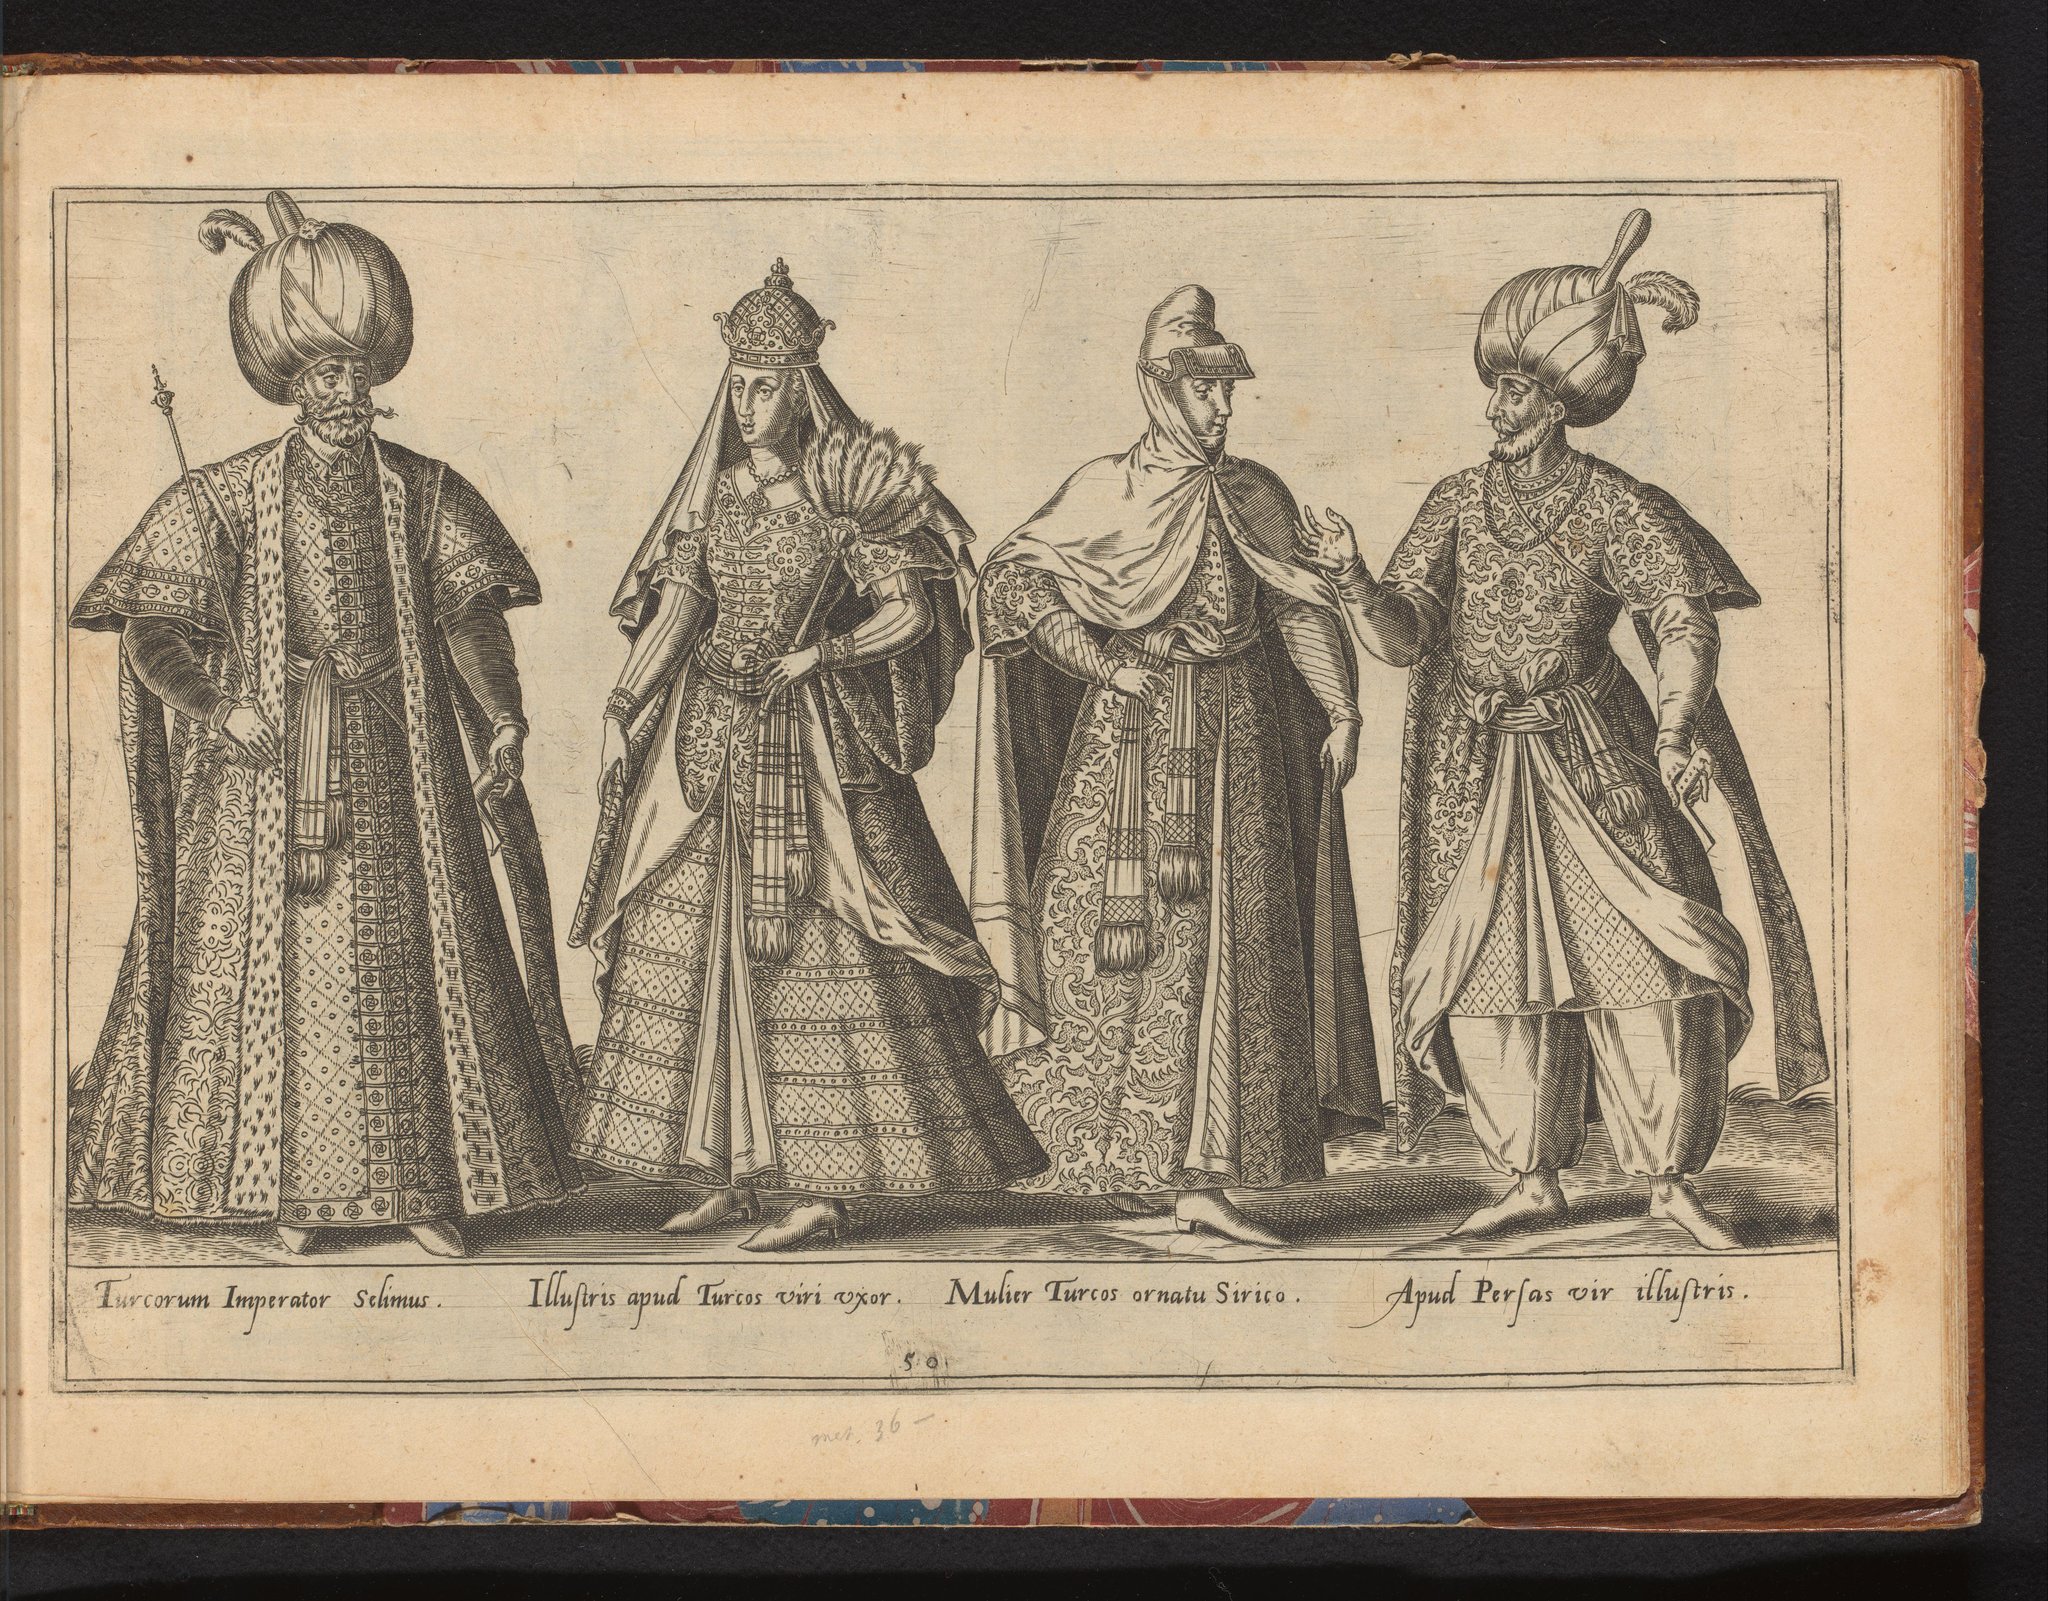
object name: costume print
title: Twee Turkse mannen en twee vrouwen, gekleed volgens de mode van ca. 1580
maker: abraham de bruyn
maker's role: print maker, publisher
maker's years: 1540-1587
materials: paper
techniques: engraving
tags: asiatic races and peoples: turks (+ costume)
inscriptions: number: ‘50’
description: Prent uit het boek 'Omnium pene Europae, Asiae, Aphricae atque Americae gentium habitus...', 1581. De prent maakt deel uit van een album.